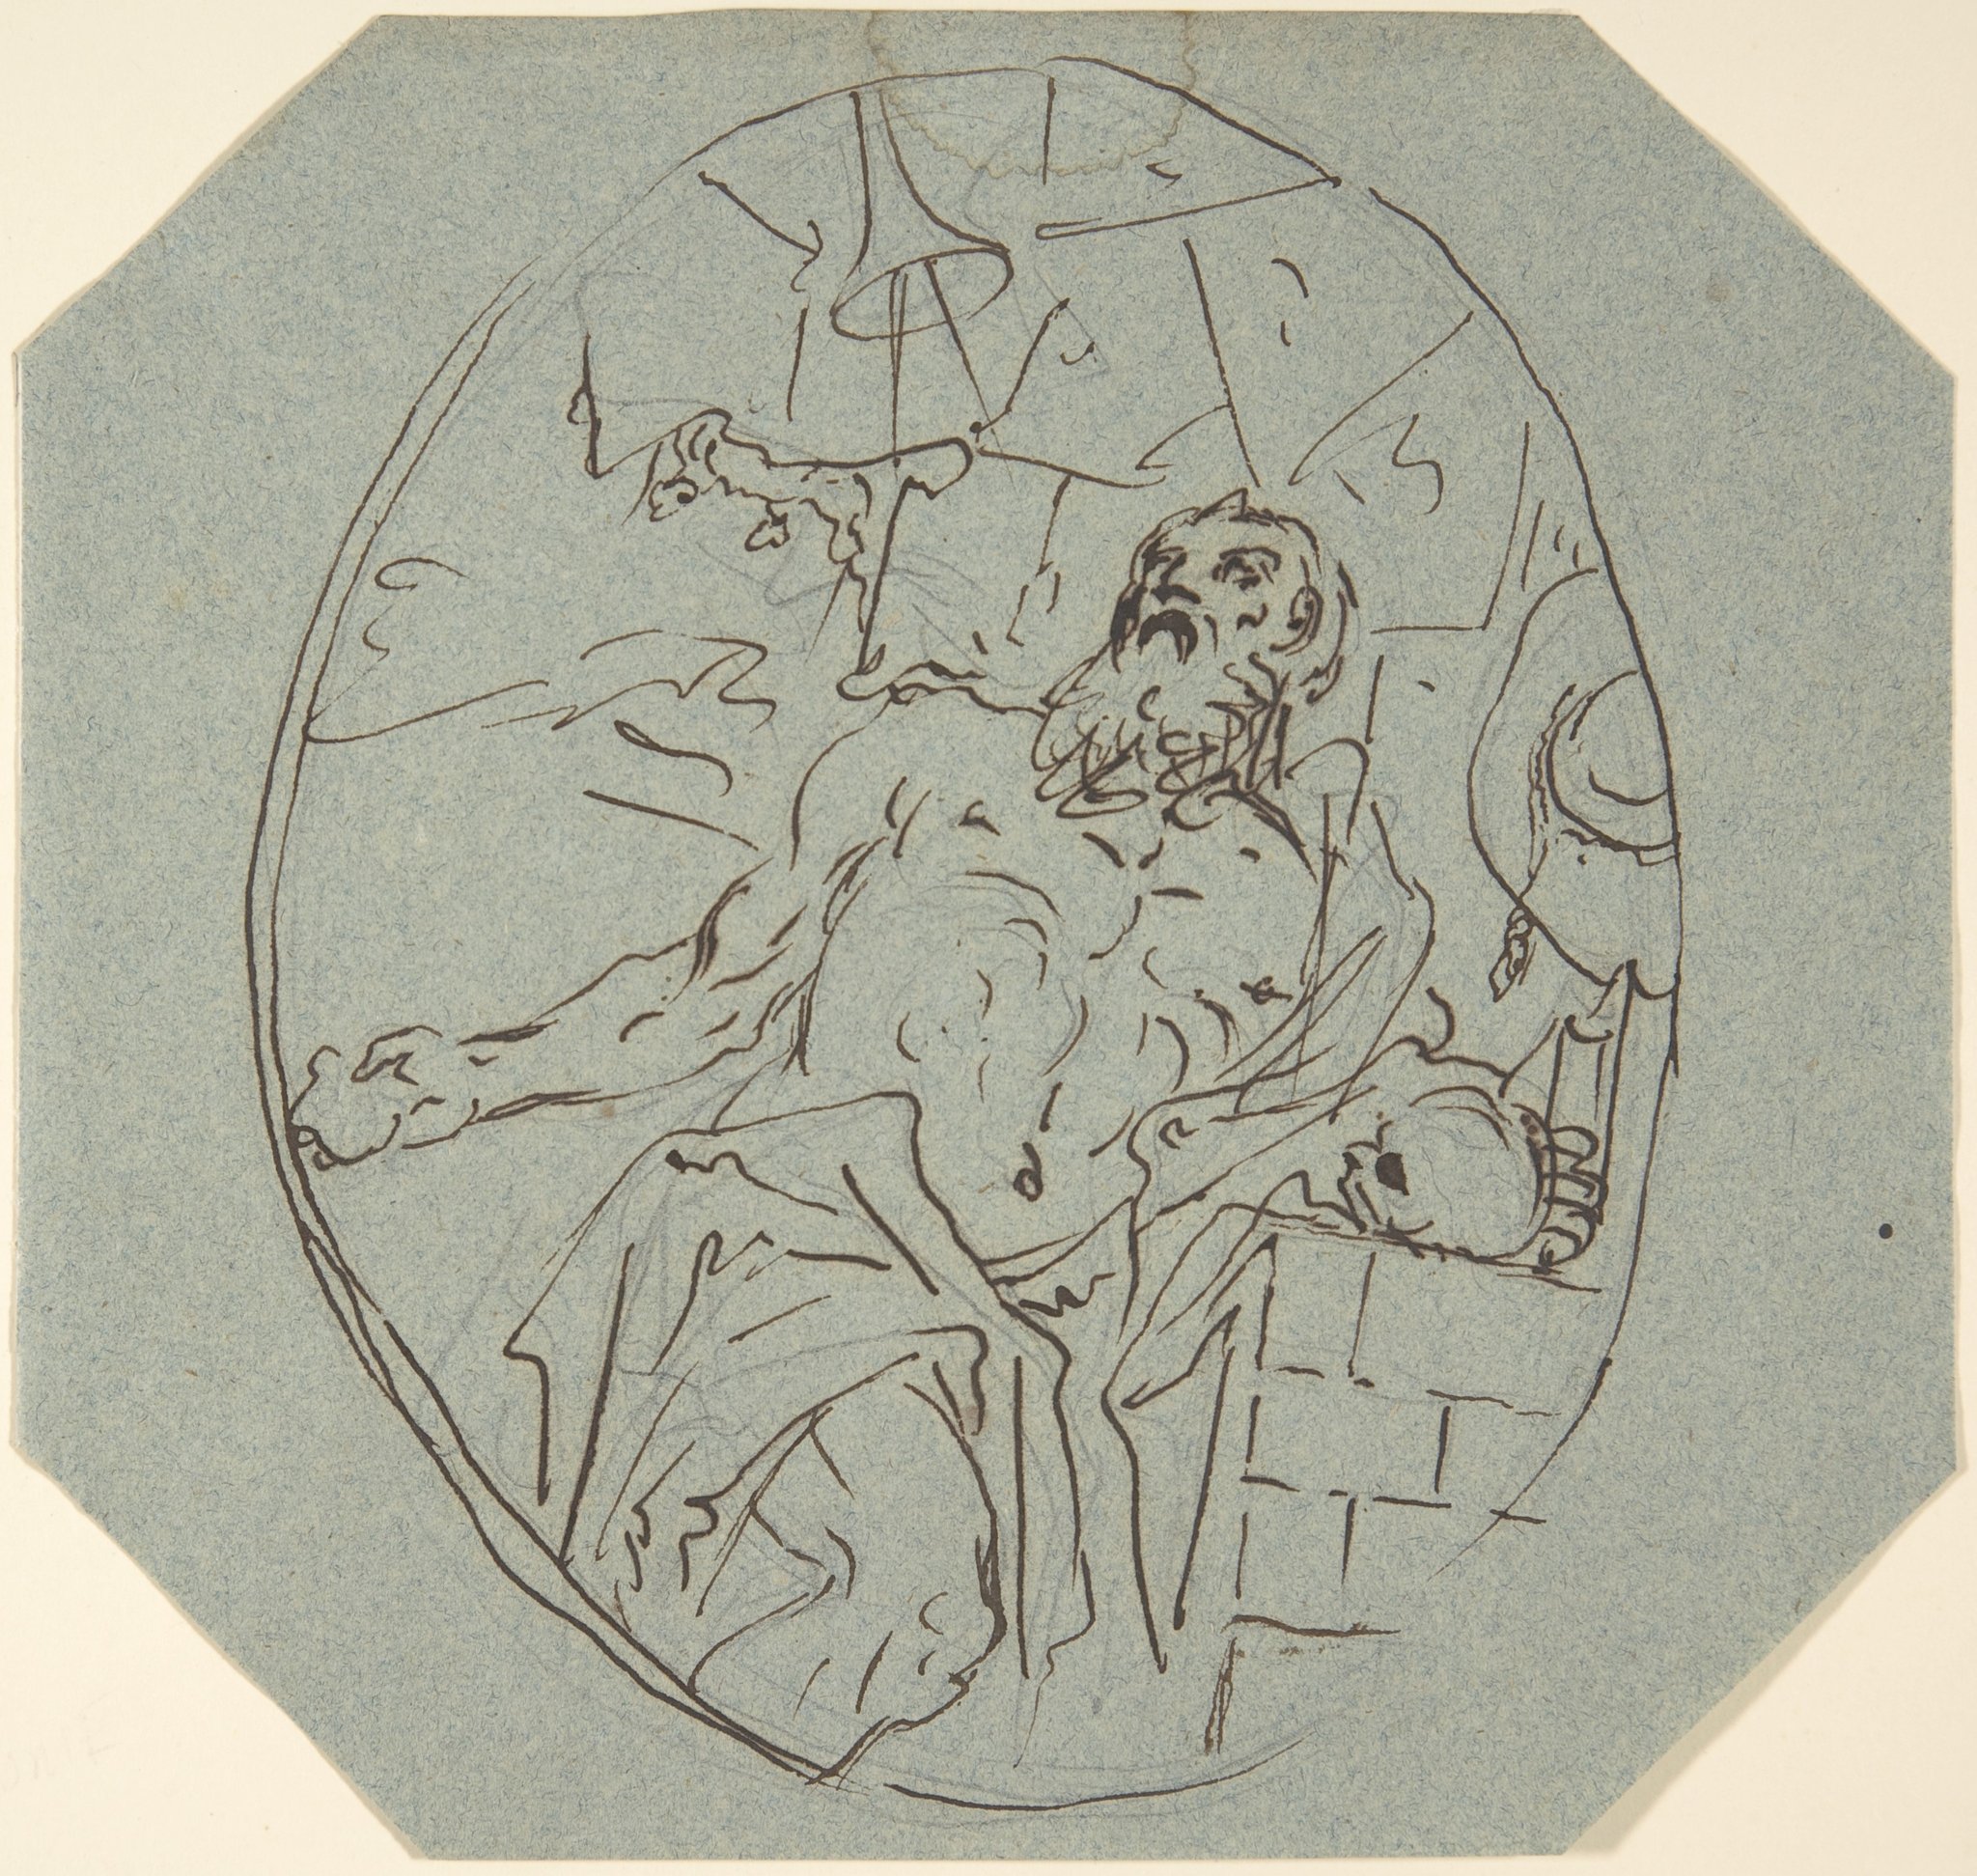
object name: drawing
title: Saint Augustus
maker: georg anton urlaub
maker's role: artist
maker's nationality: german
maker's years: 1713-1759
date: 1713-1759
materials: ink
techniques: pen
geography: germany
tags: men